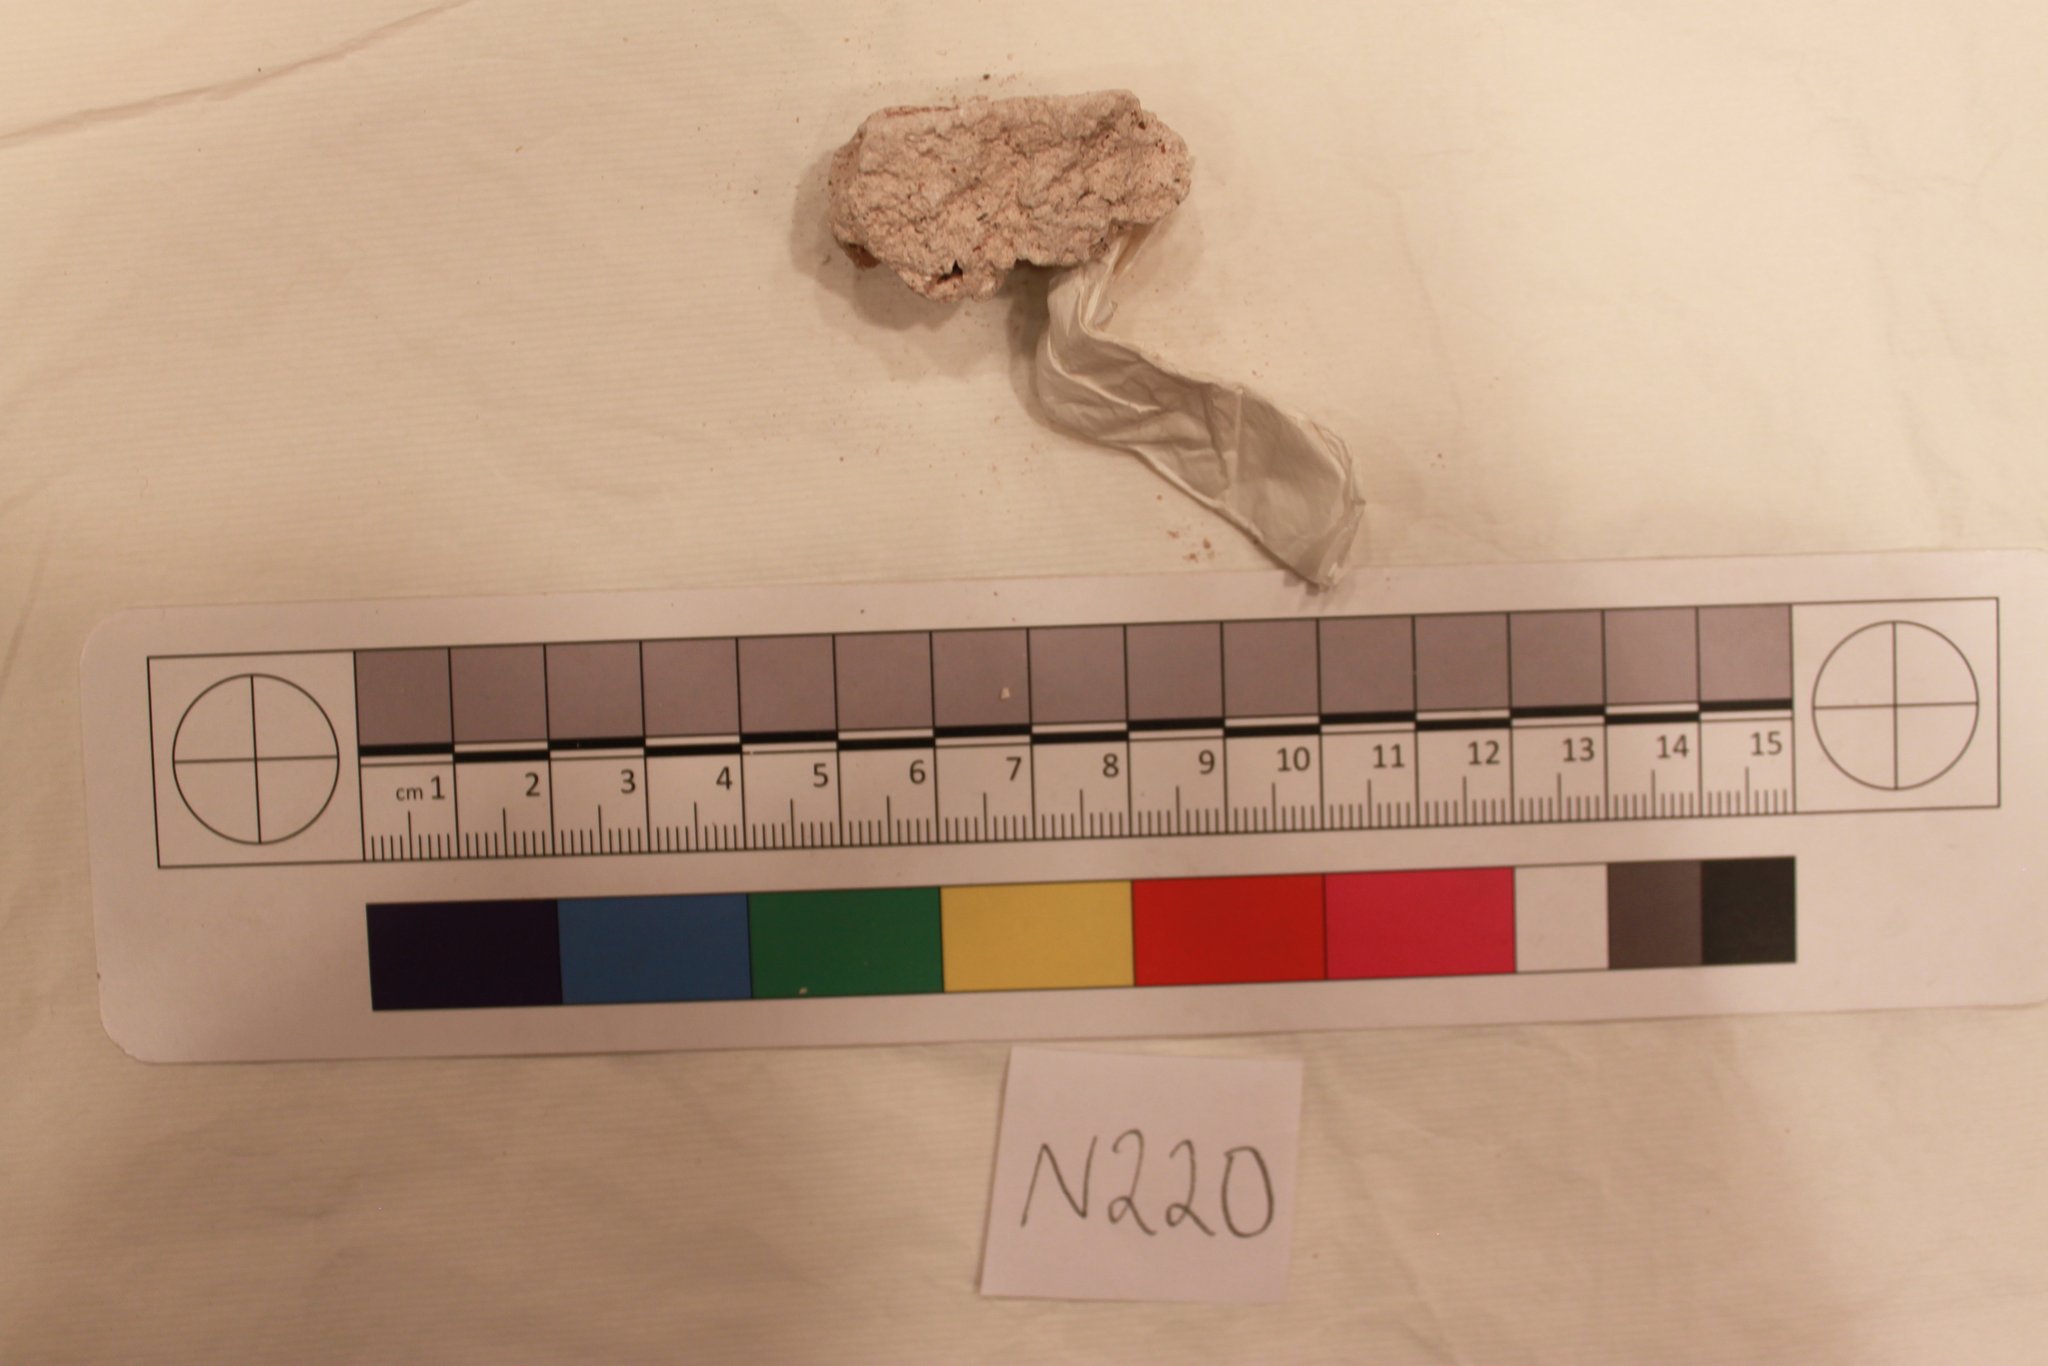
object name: fragment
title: Stucco Fragment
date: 701-1200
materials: plaster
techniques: carving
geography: iran